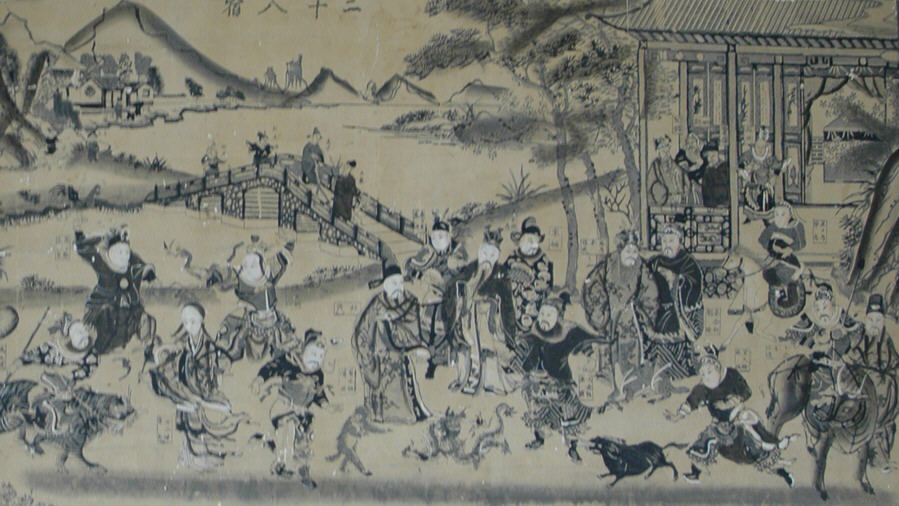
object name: print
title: Twenty-eight Star Gods of Longevity, Rank, and Happiness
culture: chinese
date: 1801-1900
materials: ink, paper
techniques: polychrome, woodblock print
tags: animals,men,horses